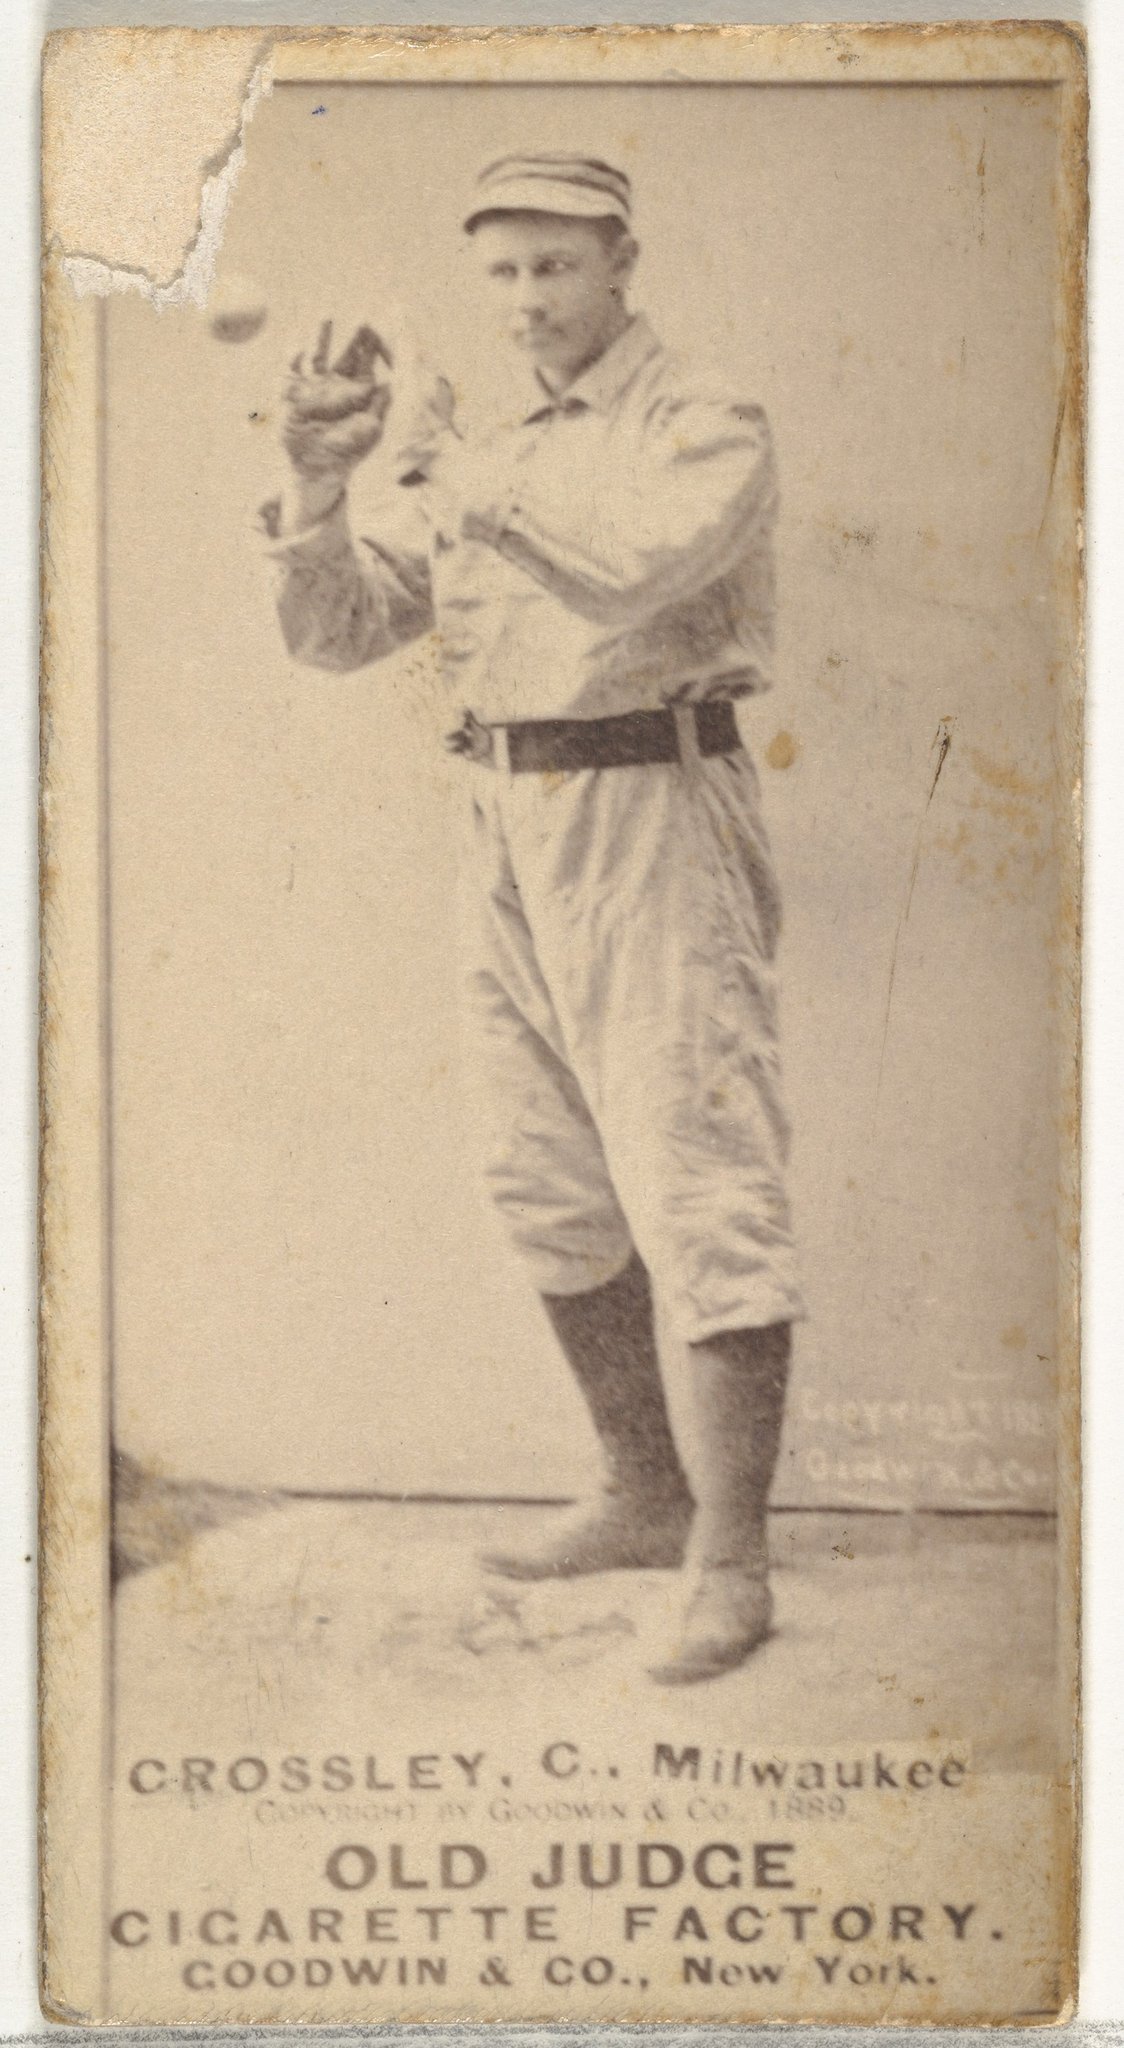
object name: baseball card, photograph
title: William C. Crossley, Catcher, Milwaukee, from the Old Judge series (N172) for Old Judge Cigarettes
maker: goodwin & company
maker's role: publisher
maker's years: 1850-1950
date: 1889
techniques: albumen silver print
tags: men,portraits,baseball,athletes